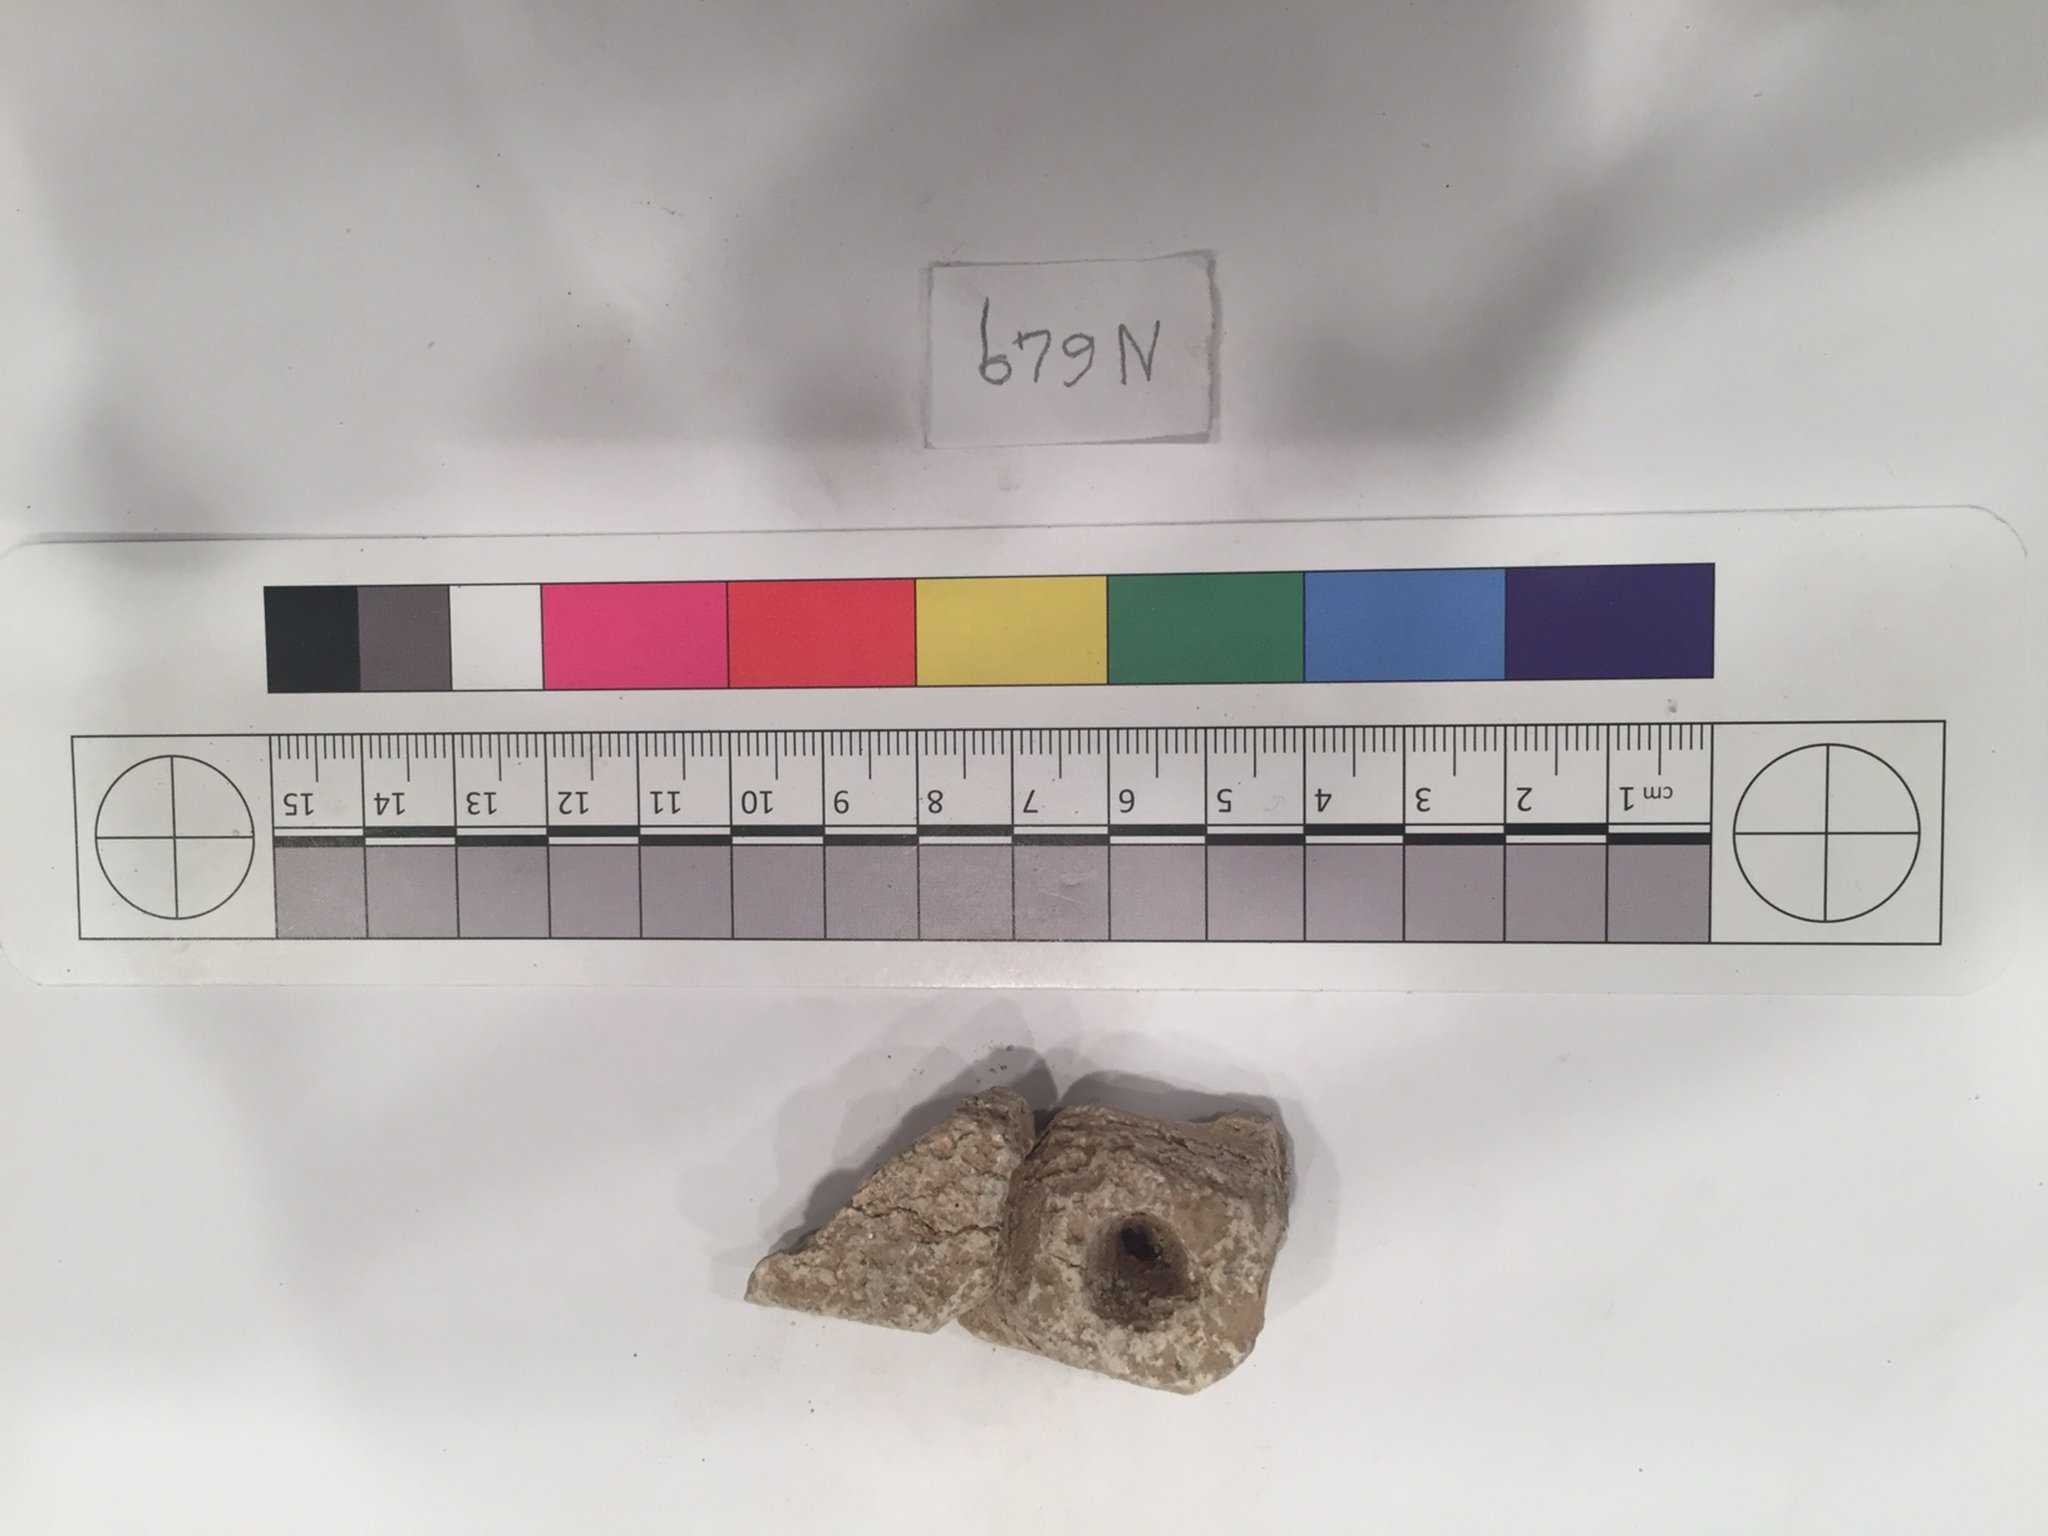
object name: fragment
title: Stucco Fragment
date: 701-1200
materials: plaster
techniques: carving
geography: iran